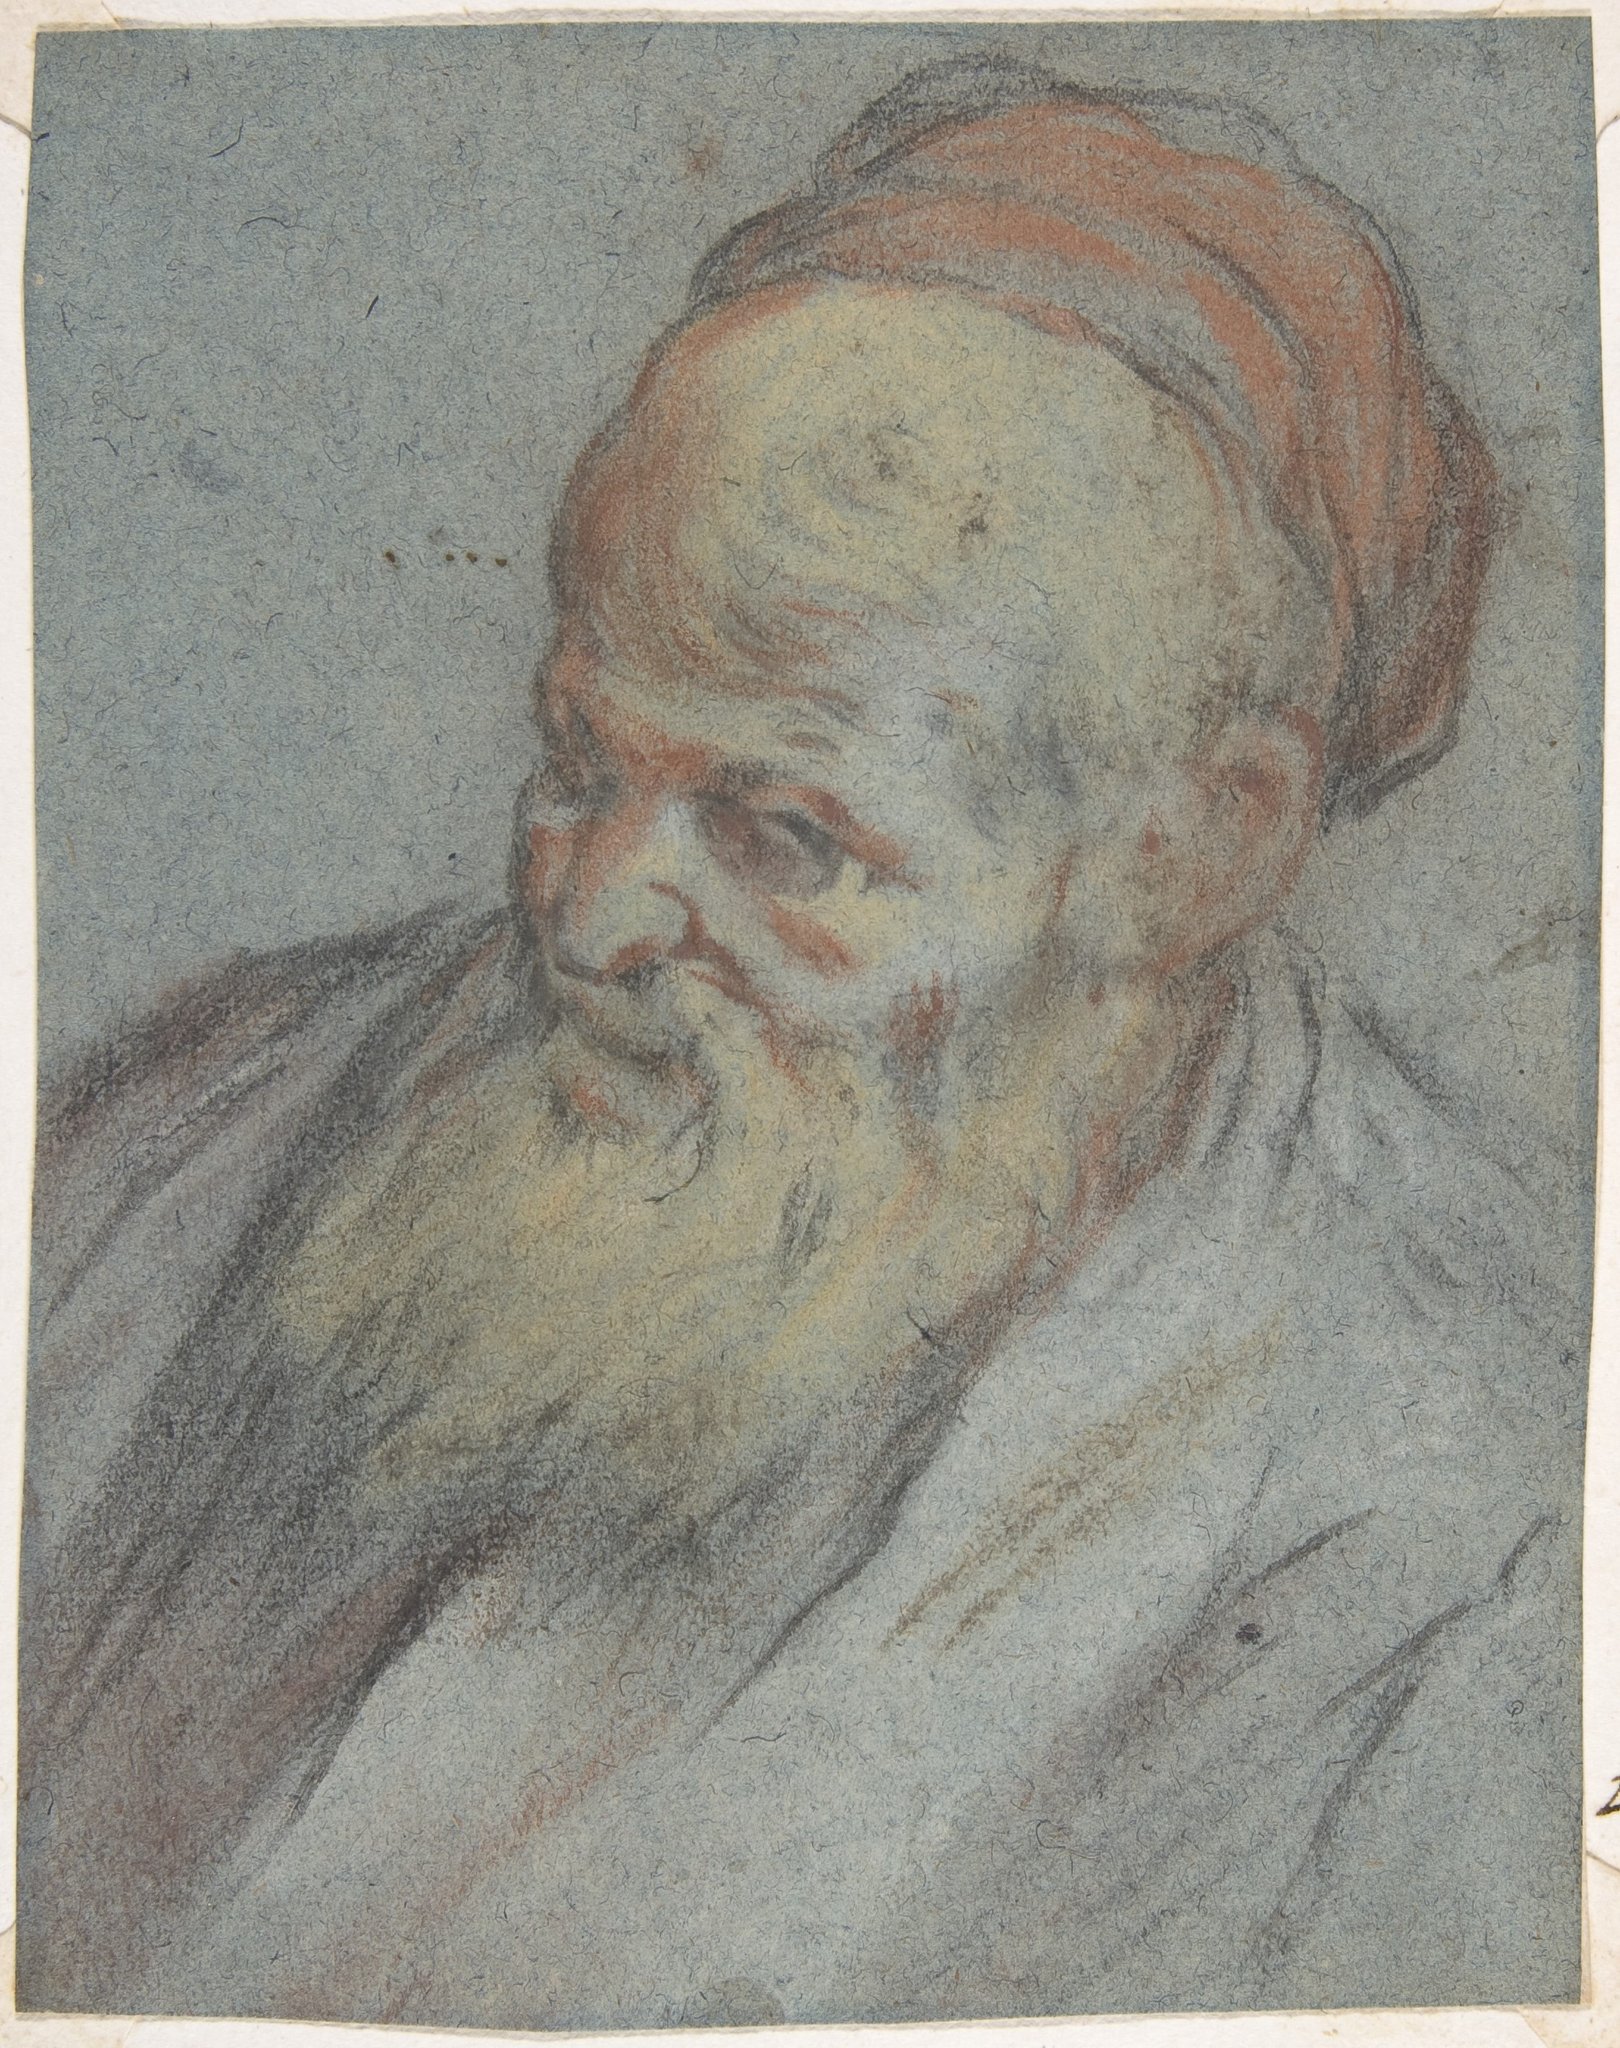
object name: drawing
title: Bust-Length Study of a Bearded Man with Cap in Three-Quarter View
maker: jacopo bassano (jacopo da ponte)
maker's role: artist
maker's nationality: italian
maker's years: 1510-1592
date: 1510-1592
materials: charcoal, paper, pastel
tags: men